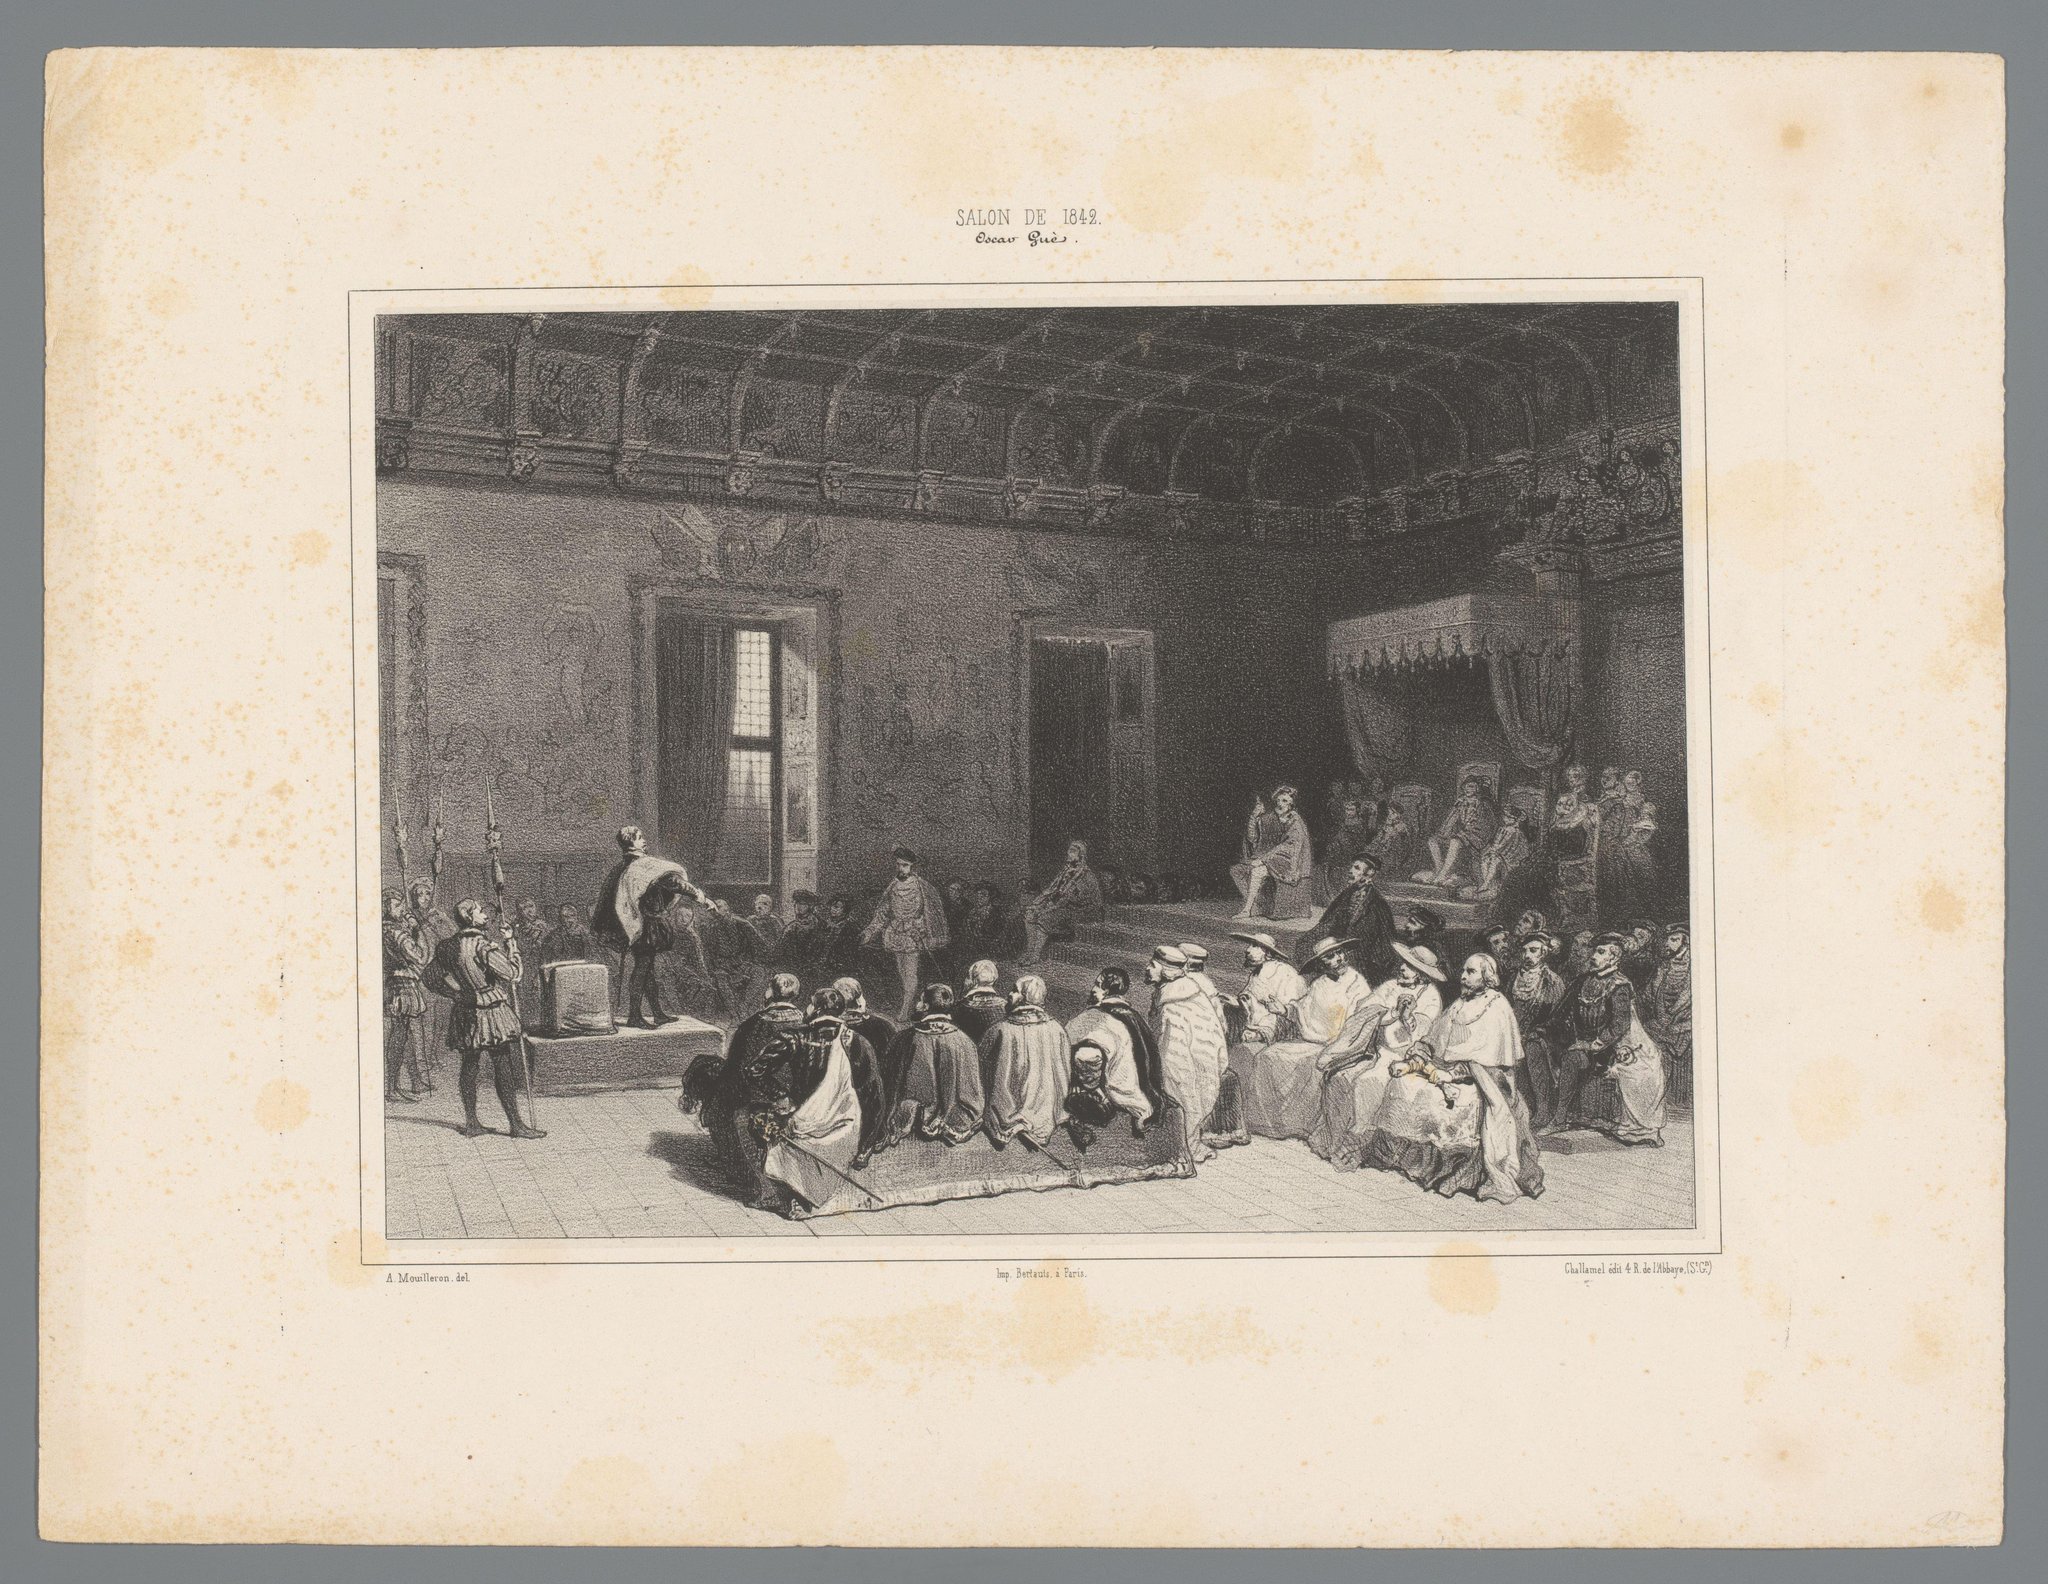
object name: print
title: Lodewijk van Bourbon-Condé aan het hof van koning Frans II van Frankrijk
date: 1842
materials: paper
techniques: lithograph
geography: paris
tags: palace - aa - civic architecture: inside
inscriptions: collector's mark: Lugt 964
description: Prent gebruikt in: Ténint, Wilhelm. Album du Salon de 1842. Collection des principaux ouvrages exposés au Louvre (…). Parijs: Augustin Challamel, 1842.